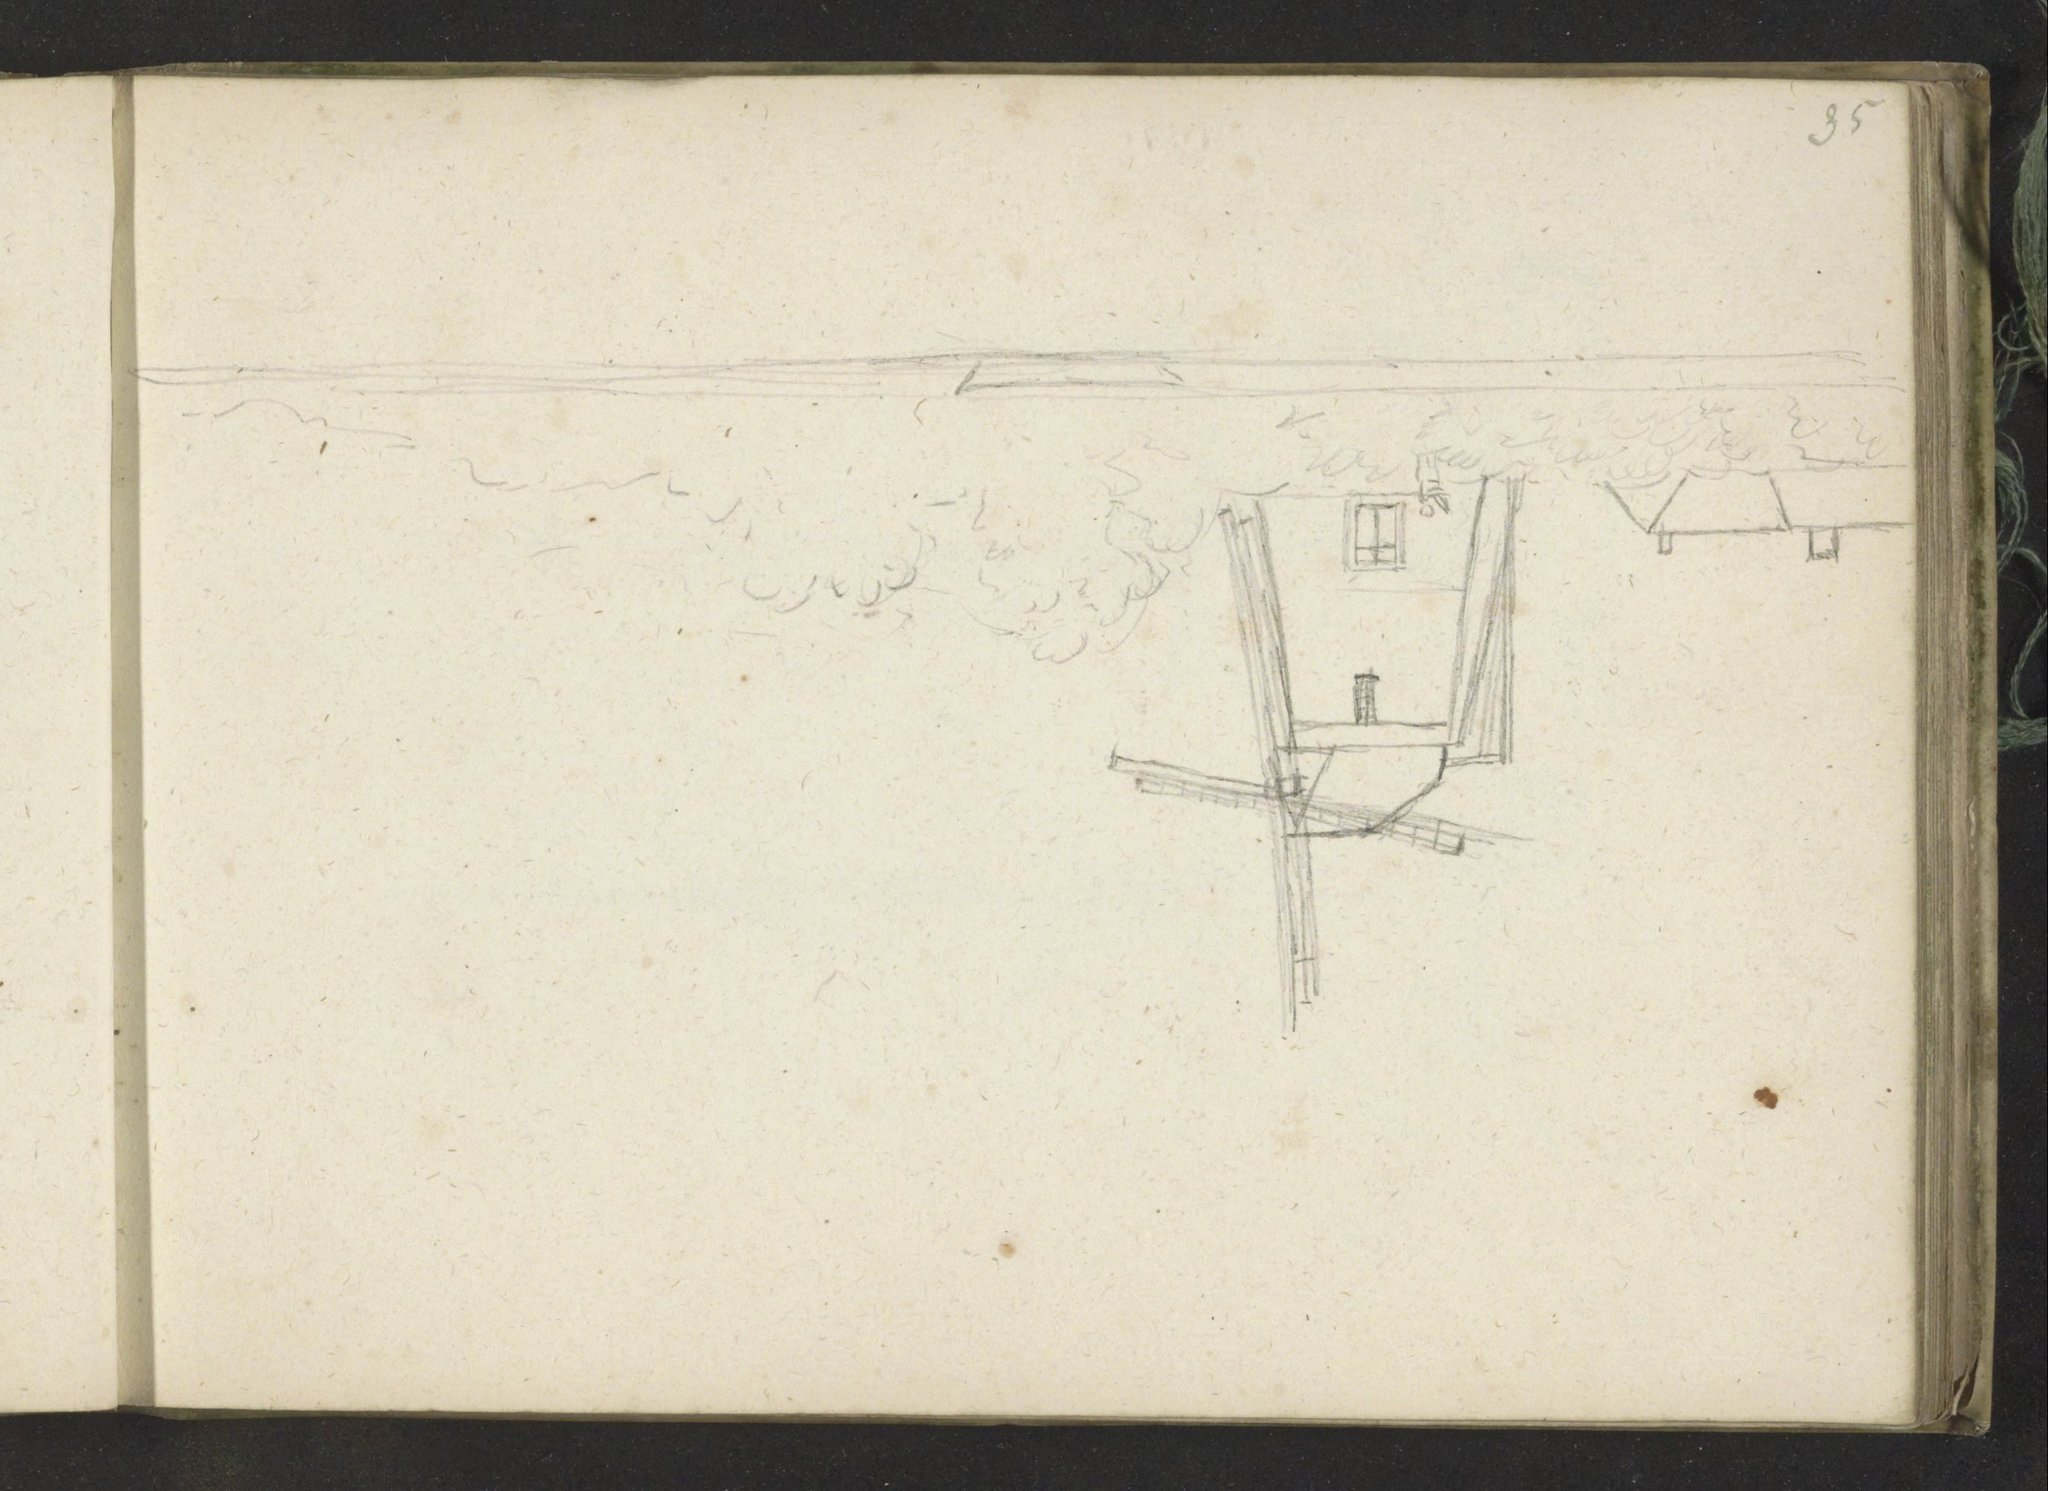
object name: sketchbook leaf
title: Molen aan een waterkant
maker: martinus schouman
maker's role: draughtsman, painter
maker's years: 1770-1848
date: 1780-1848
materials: paper, pencil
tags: landscapes with waters, waterscapes, seascapes (in the temperate zone), windmill in landscape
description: Blad 35 recto uit een schetsboek met 53 bladen.